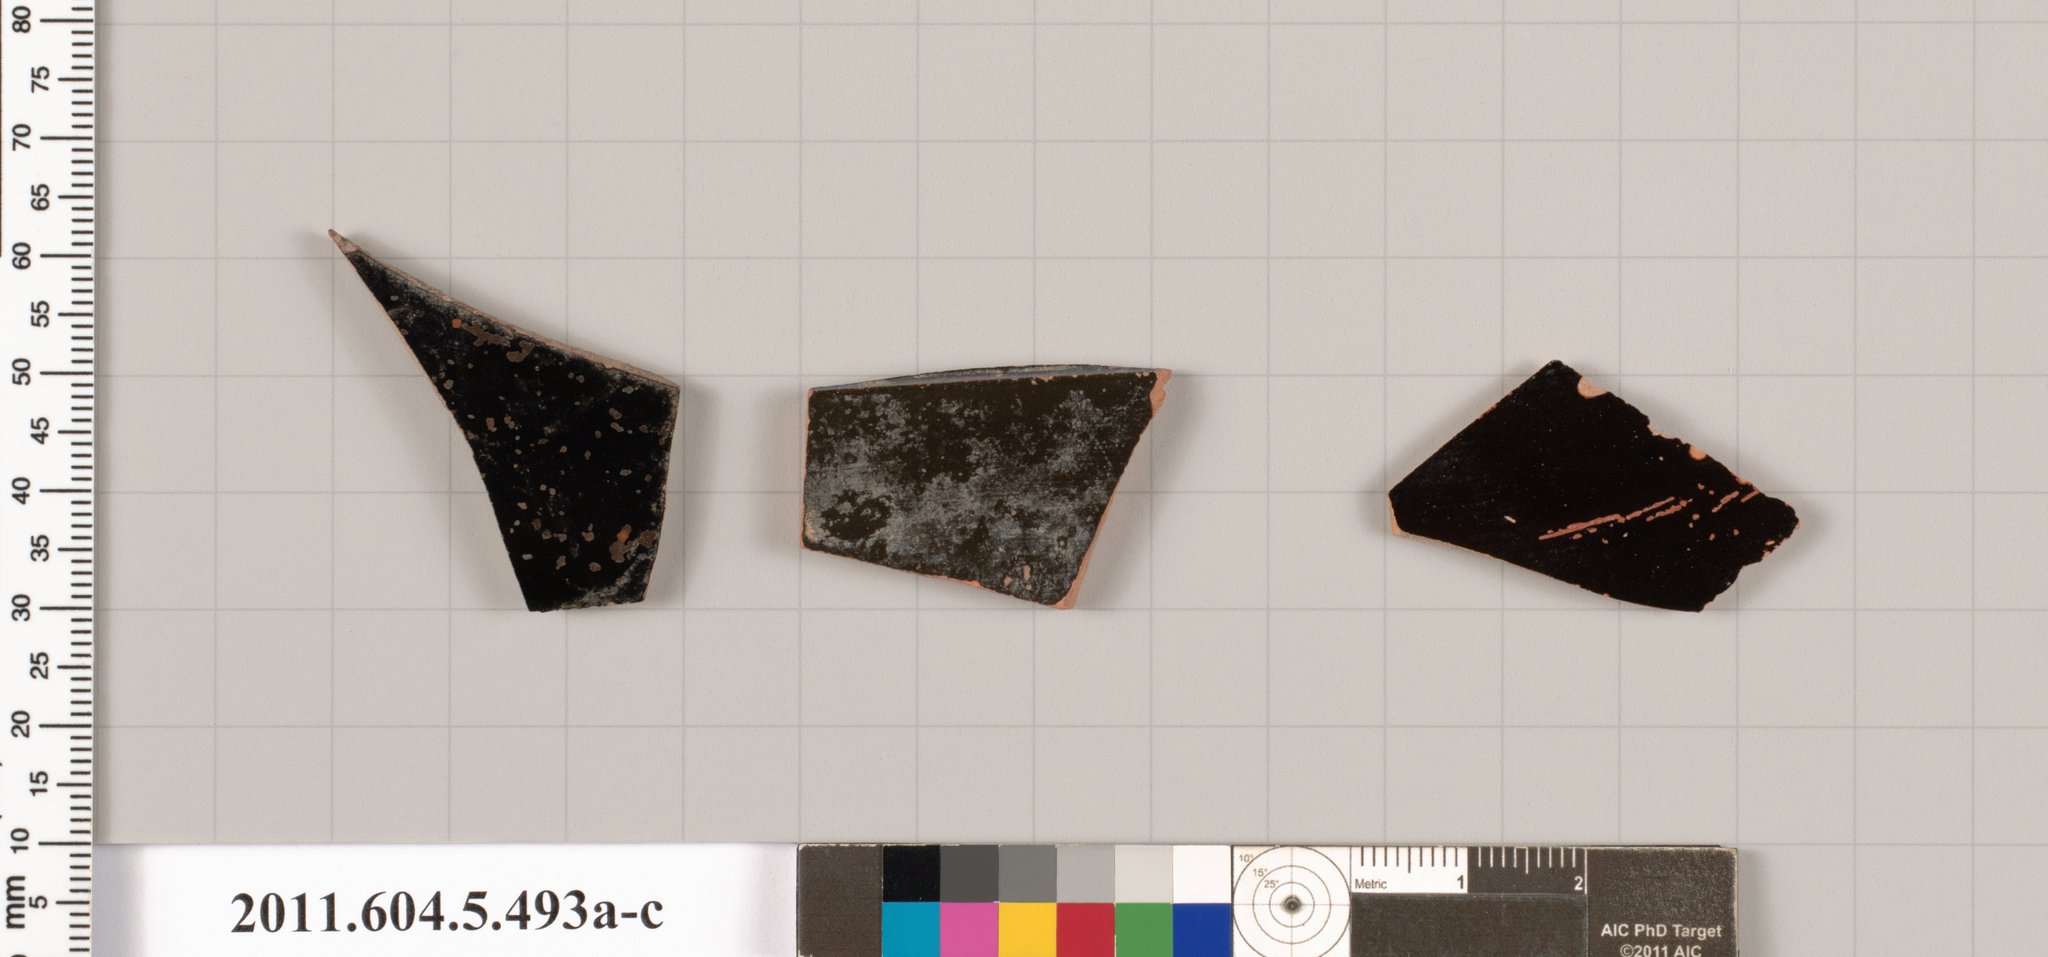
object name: kylix fragment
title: Terracotta fragments of kylikes (drinking cups)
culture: greek, attic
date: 600-401 BCE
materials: terracotta